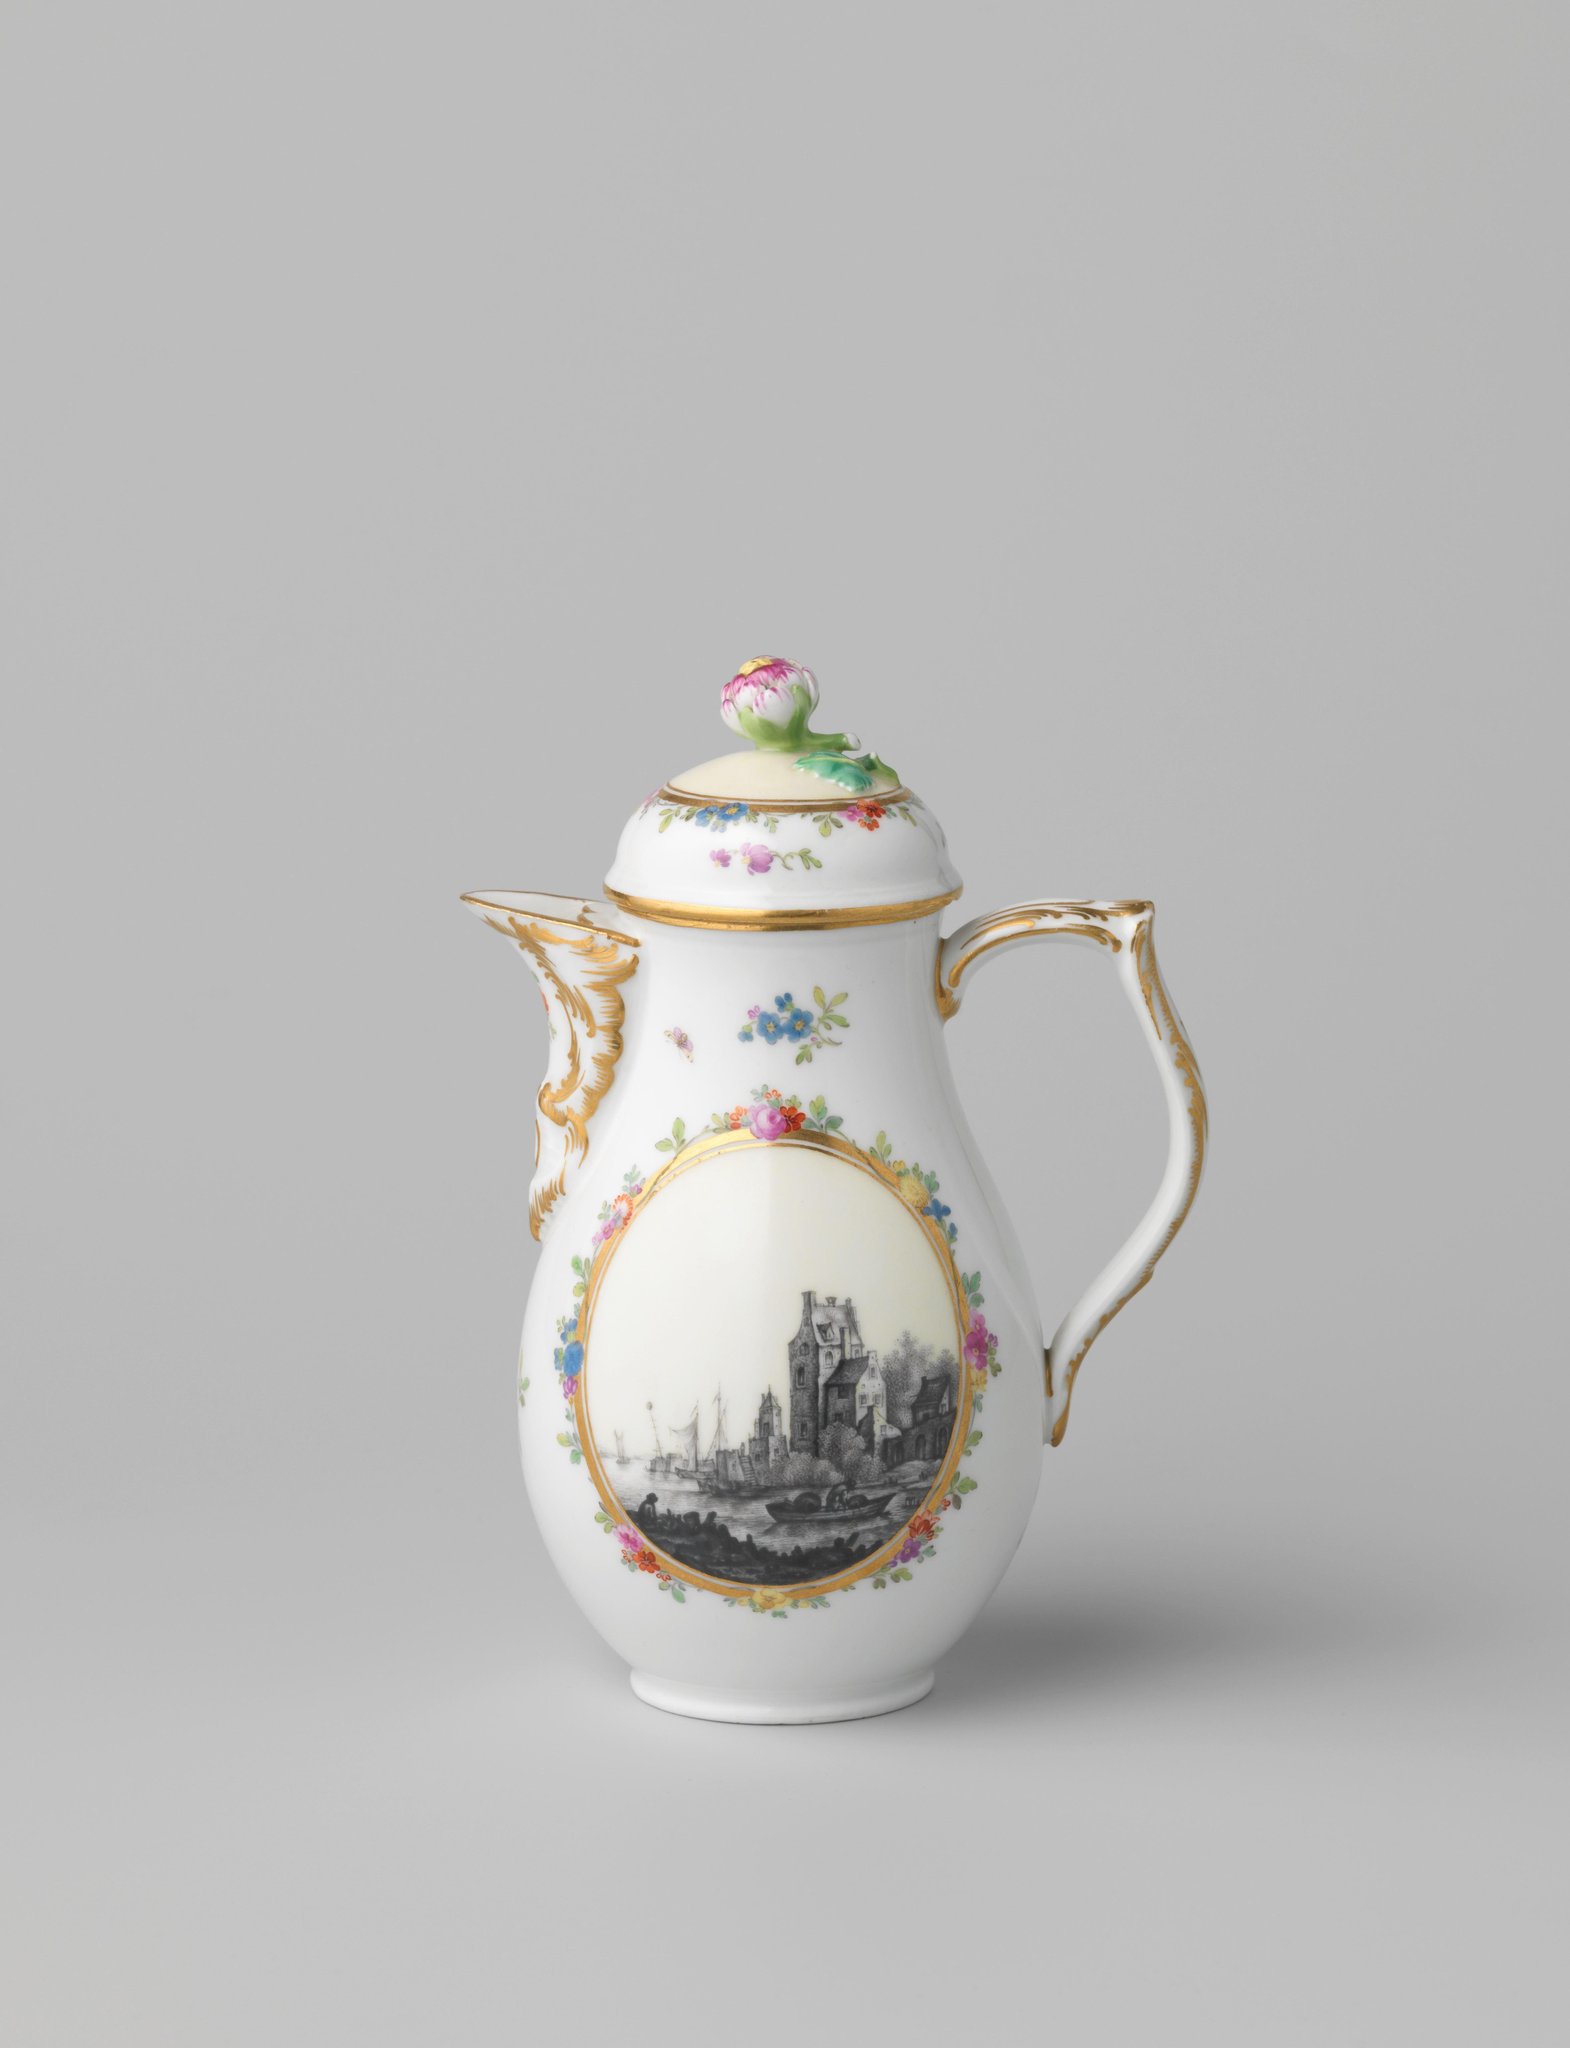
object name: coffee pot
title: Coffee pot with a landscape and flower sprays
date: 1780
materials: glaze, gold, paint, porcelain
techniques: firing, forming, gilding, turning, vitrification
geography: berlin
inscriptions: mark: ‘scepter/ I’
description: Koffiepot van porselein met een peervormig lichaam, C-vormig oor en tuit vanuit de nek en rand. Beschilderd in emailkleuren en goud. Op de buik tweemaal een medaillon van bloemtakken met daarin een landschap. Het oor en de tuit zijn versierd in rocaillestijl. Gemerkt op de onderzijde met de scepter en I.